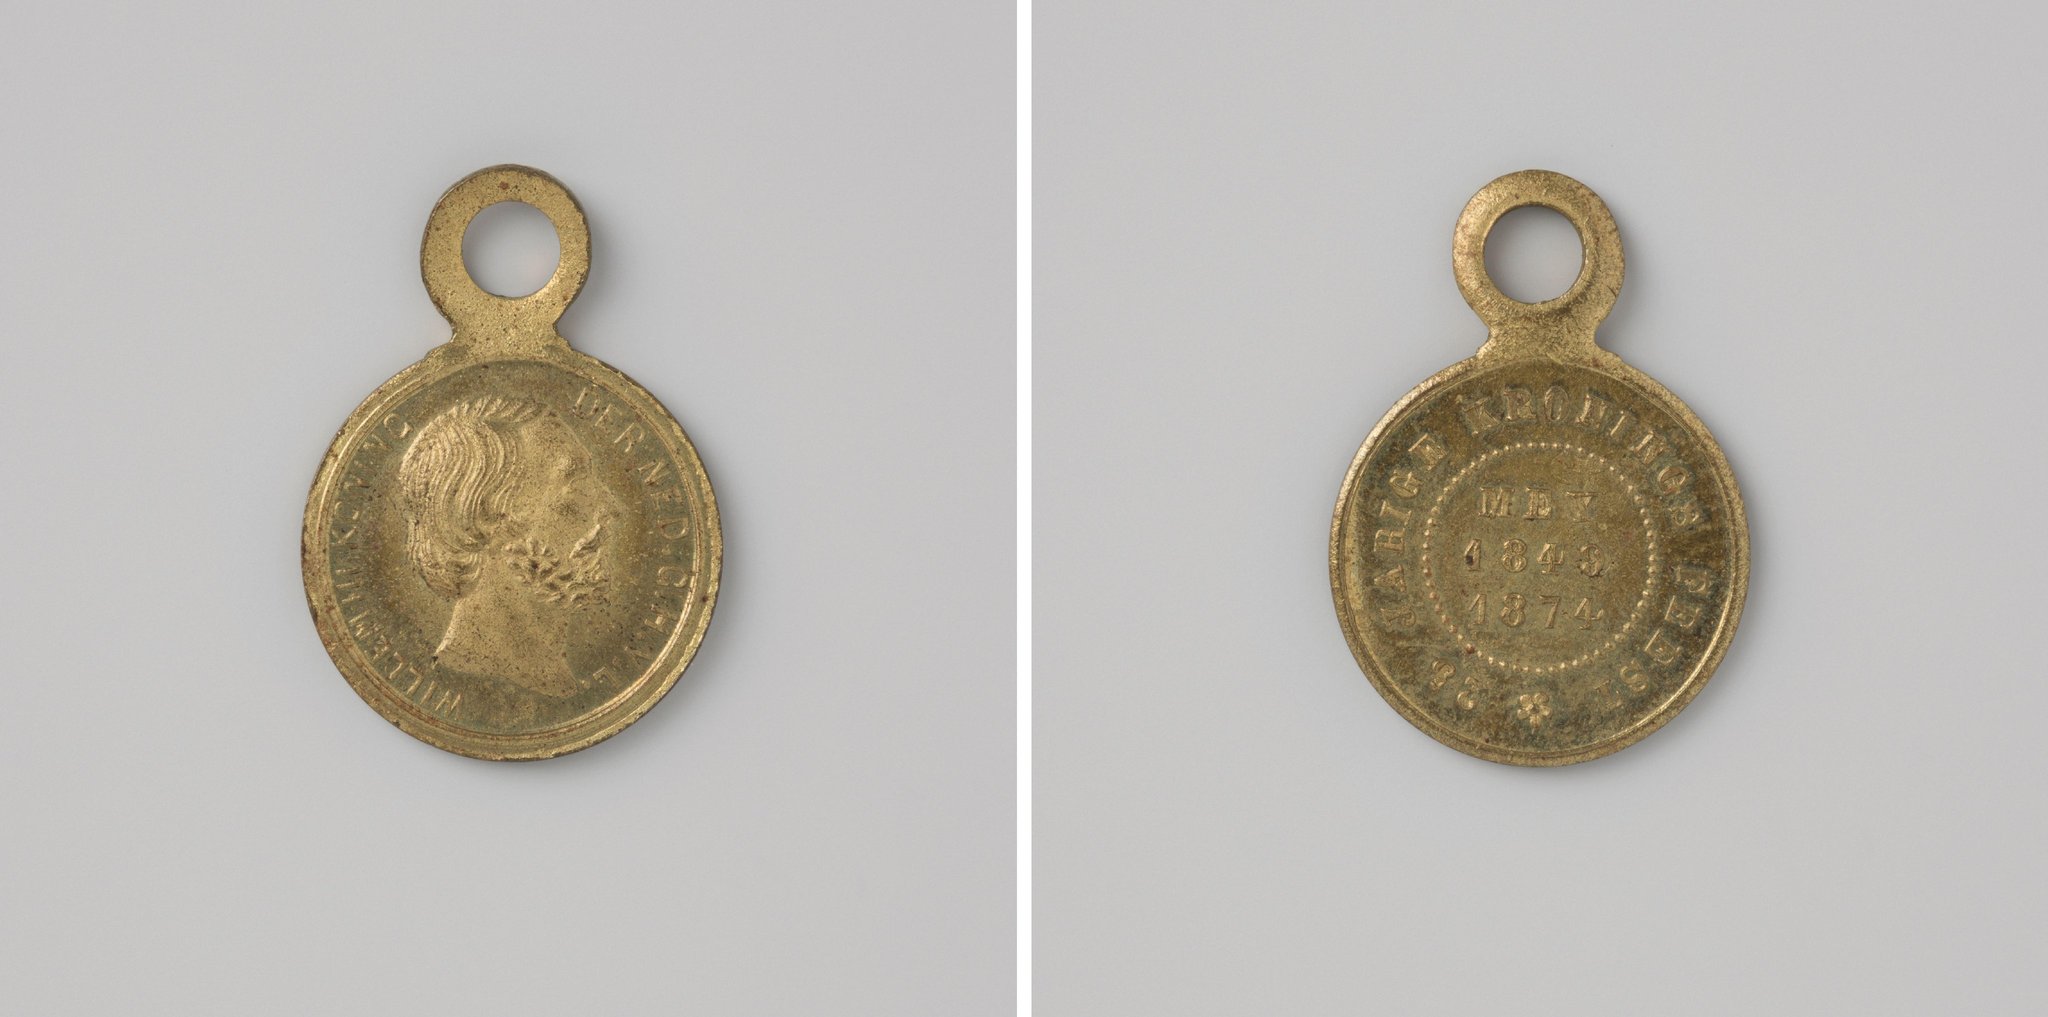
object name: history medal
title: Vijfentwintigjarig regeringsjubileum van Koning Willem III 1874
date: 1874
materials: brass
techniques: striking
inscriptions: circumscription: ‘WILLEM III KONING - DER NED. G.H.V.L.’, inscription: ‘25 JARIG KRONINGS FEEST / MEY / 1849 / 1874’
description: Messing penninkje met fors draagoog, op de voorzijde het portret van Willem III naar rechts met omschrift, op de keerzijde drie regels tekst met omschrift.